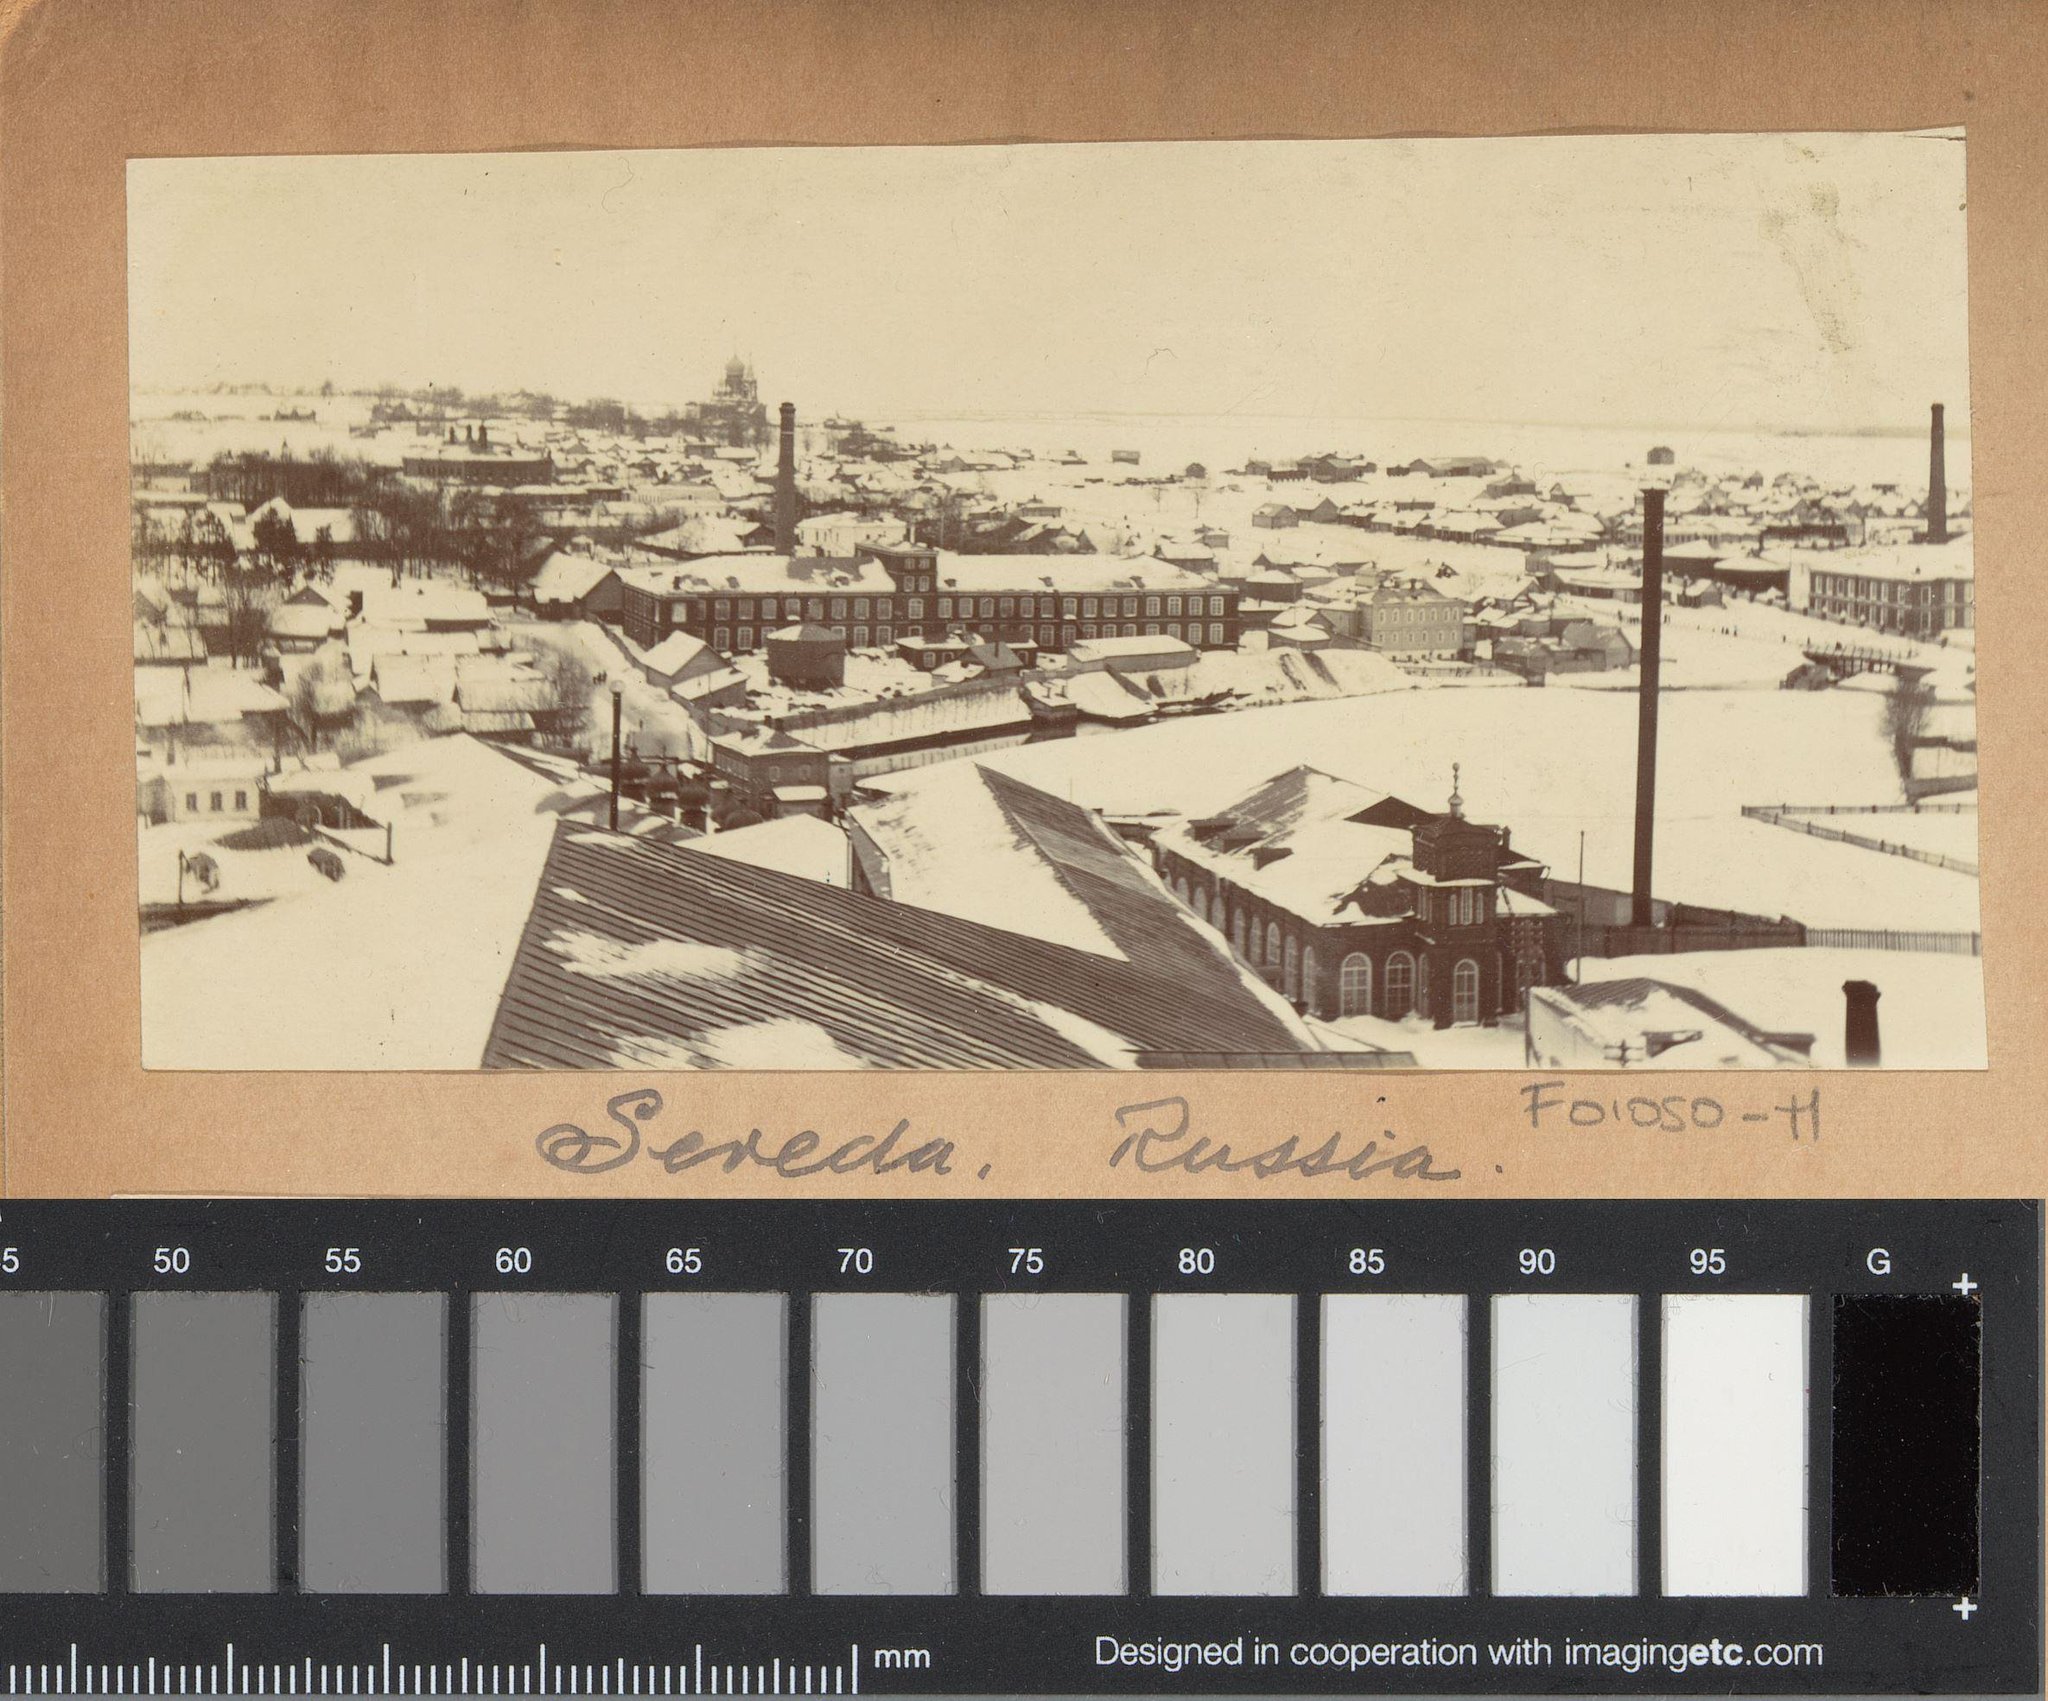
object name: photograph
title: Gezicht op besneeuwde stad Sereda in Rusland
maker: joseph cheetham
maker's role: engineer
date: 1903-1904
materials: photographic support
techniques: gelatin silver print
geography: russia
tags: smoke-stack, factory-building, snow, prospect of city, town panorama, silhouette of city, russia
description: Sereda is de plaats waar de fotograaf/samensteller van dit album, Joseph Cheetham, als ingenieur werkzaam was.